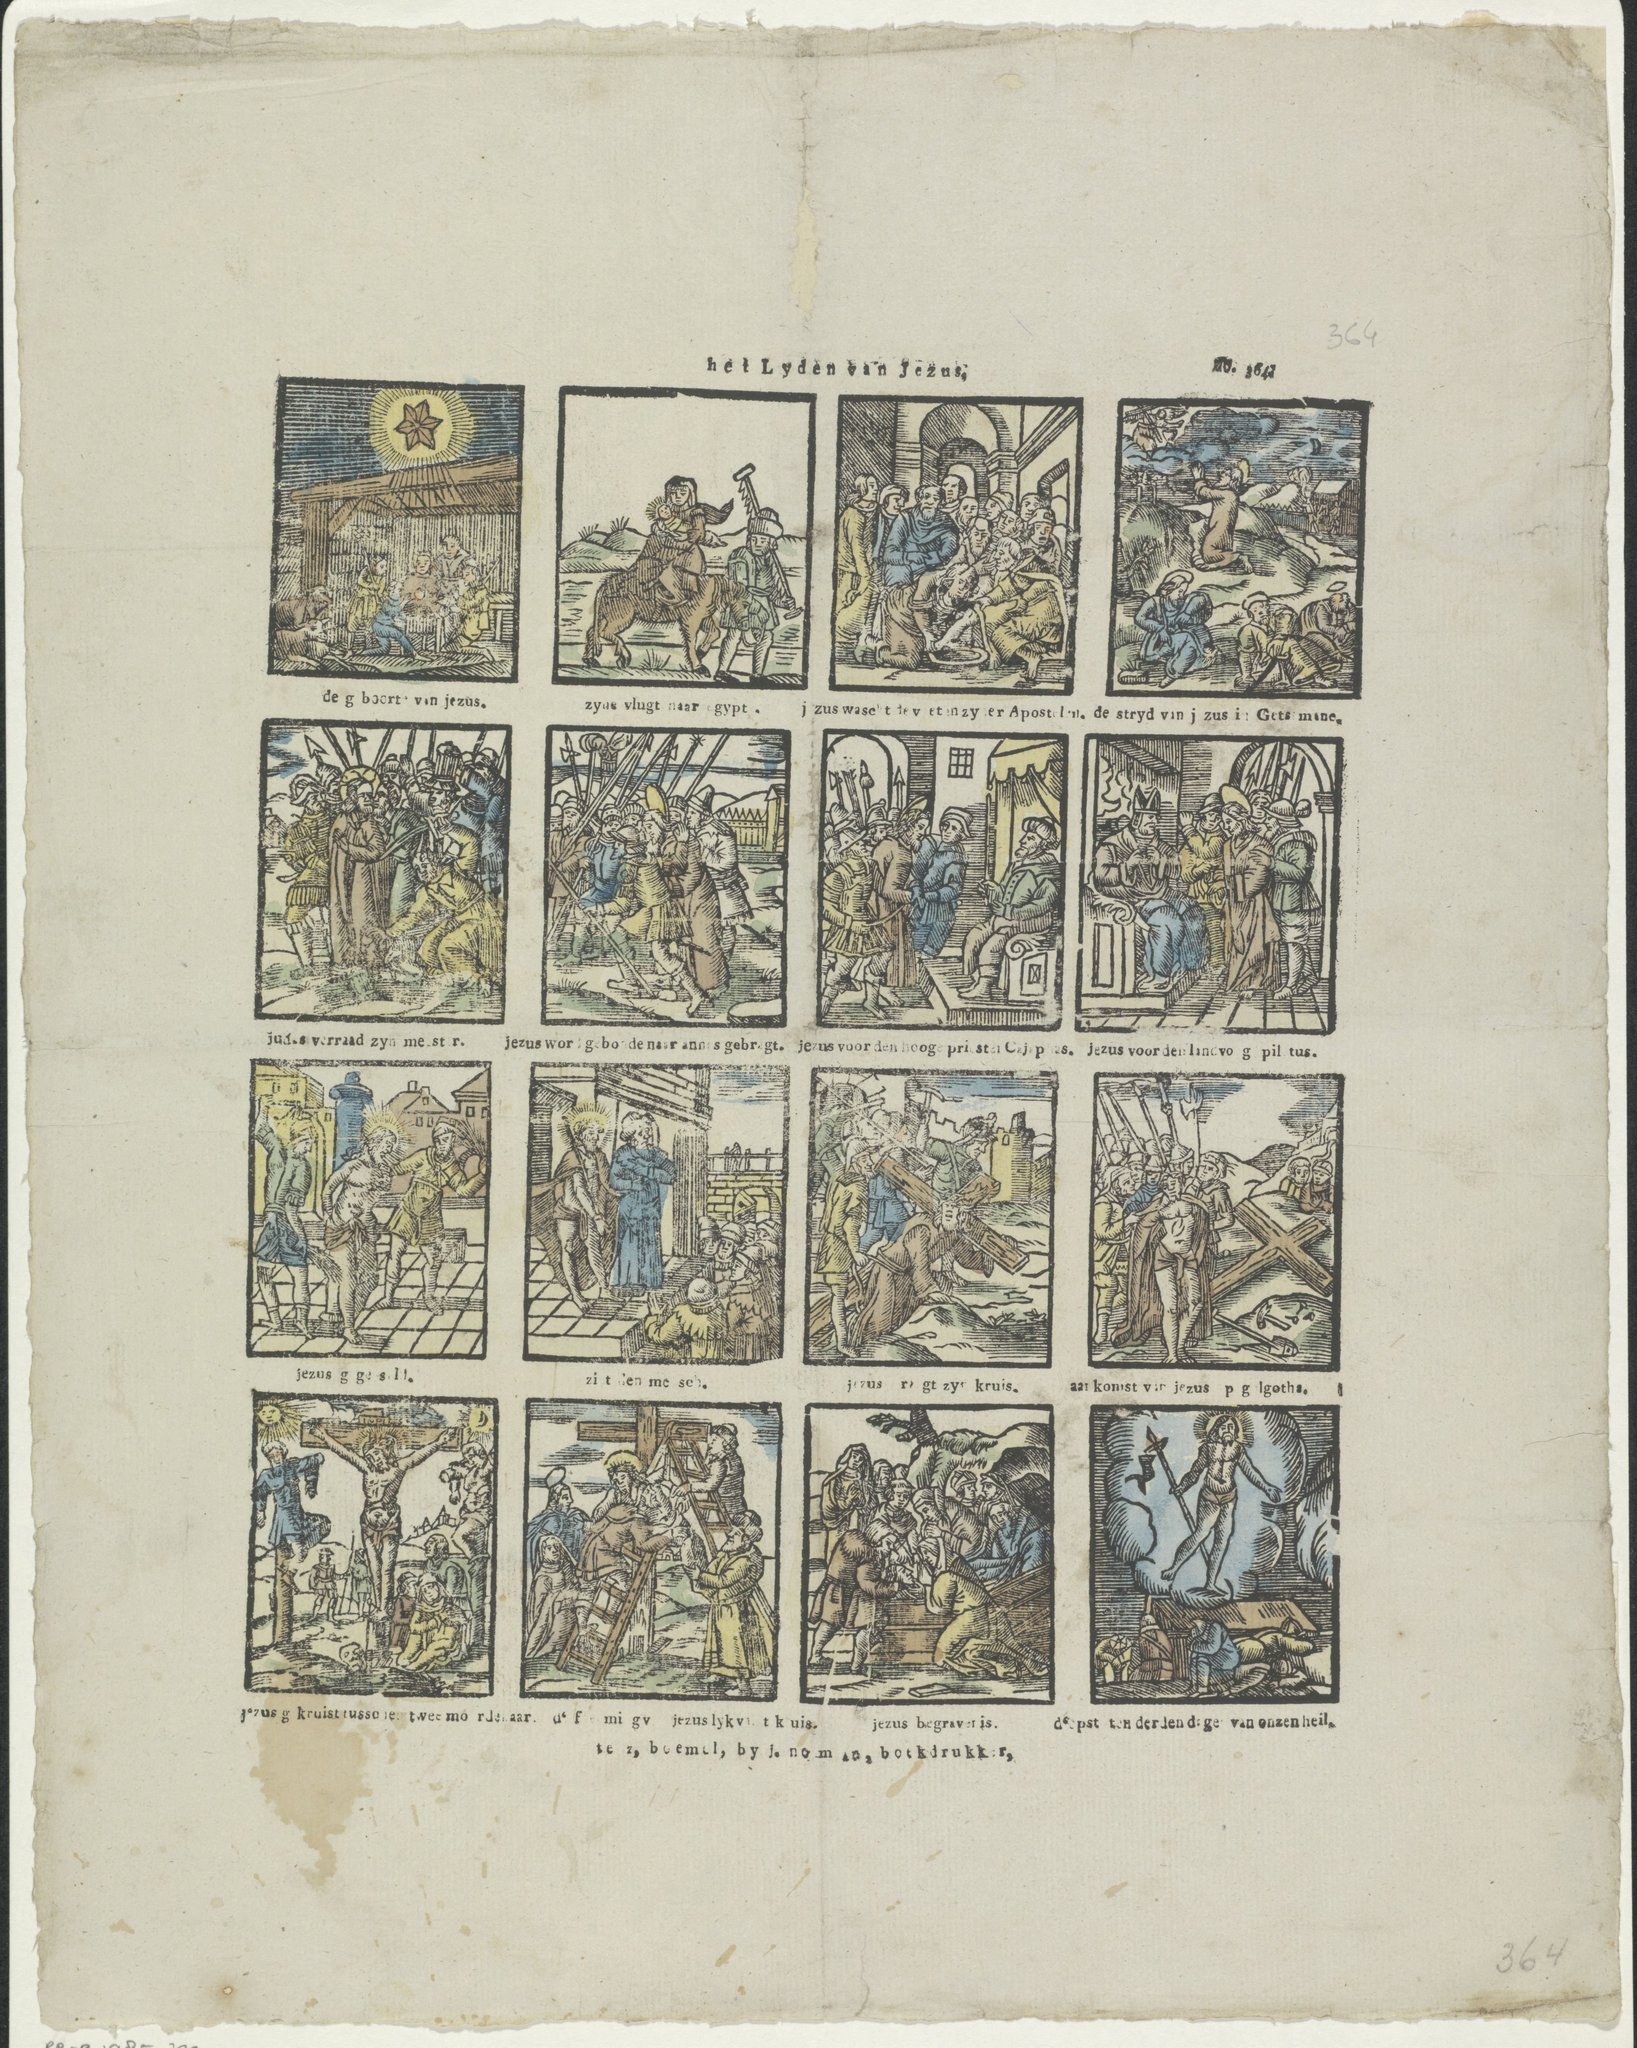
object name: popular print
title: Het lyden van Jezus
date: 1806-1830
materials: paper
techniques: colour, letterpress printing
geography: netherlands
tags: new testament, series of scenes from the life of christ, passion of christ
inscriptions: collector's mark: Lugt 2760, inscription: ‘1234K1 / 100,-’, collector's mark: Lugt 2228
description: Blad met 16 voorstellingen uit het leven van Christus, zoals de geboorte van Christus, de vlucht naar Egypte en de geseling. Onder elke afbeelding een onderschrift. Genummerd rechtsboven: No. 364.